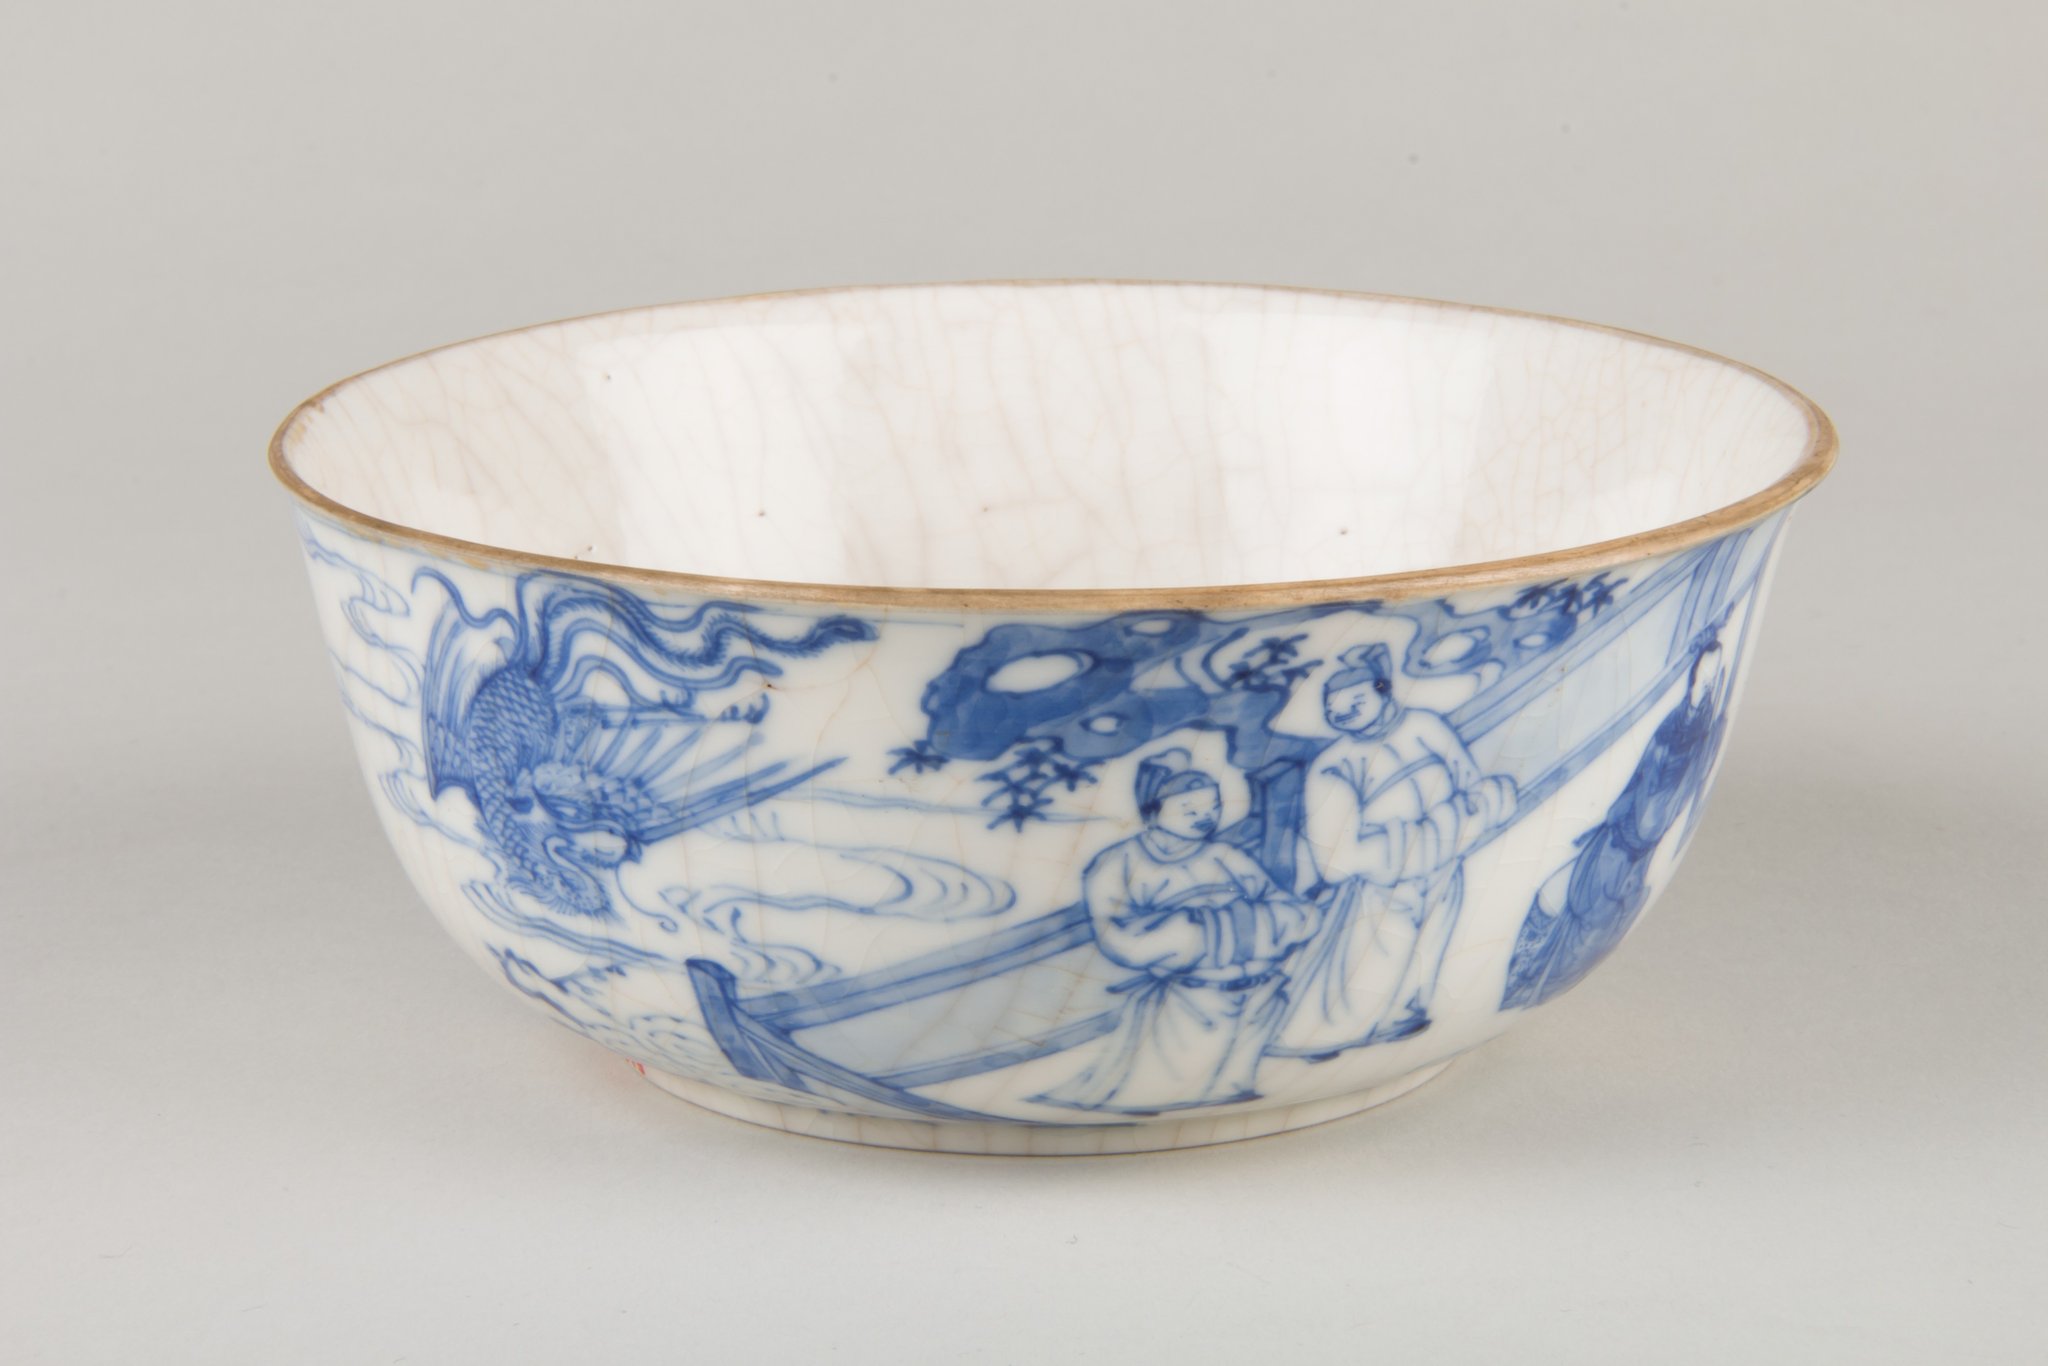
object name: bowl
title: Bowl with figural scene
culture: chinese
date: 1667-1733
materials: cobalt, porcelain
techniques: painting, underglaze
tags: human figures,trees